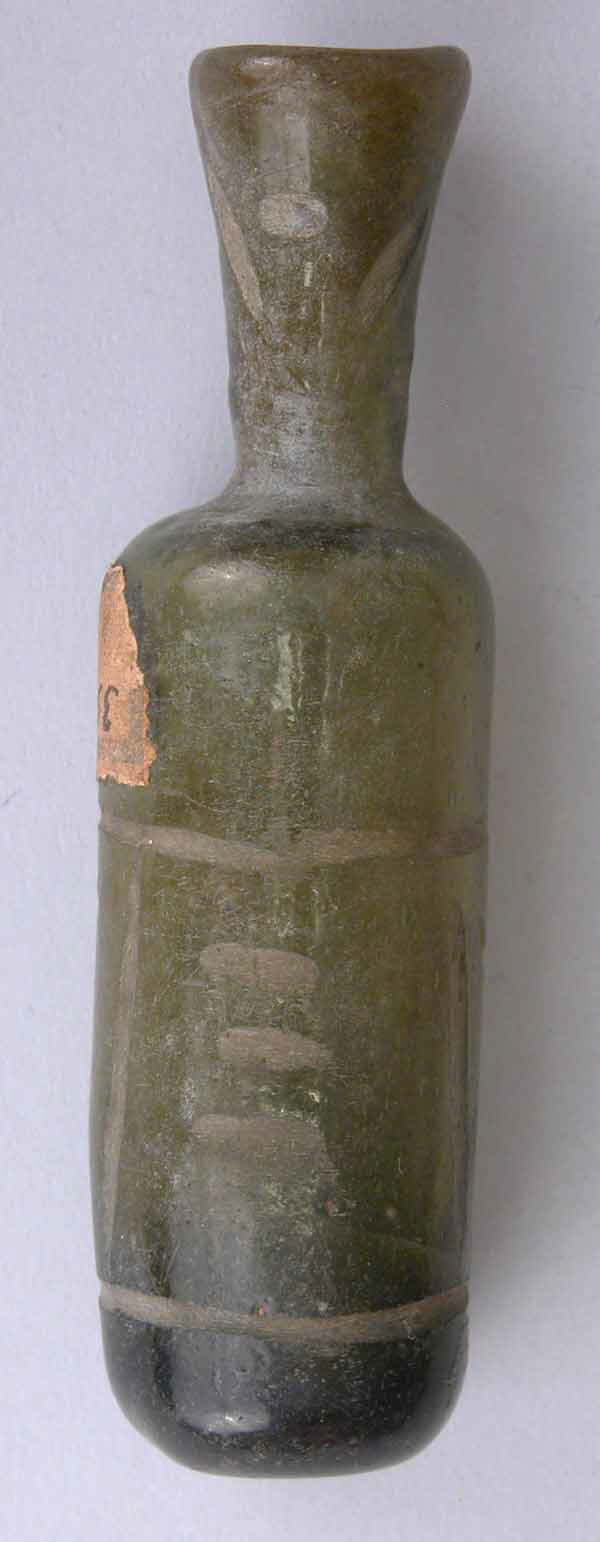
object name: bottle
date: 801-1100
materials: glass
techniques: engraving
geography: egypt